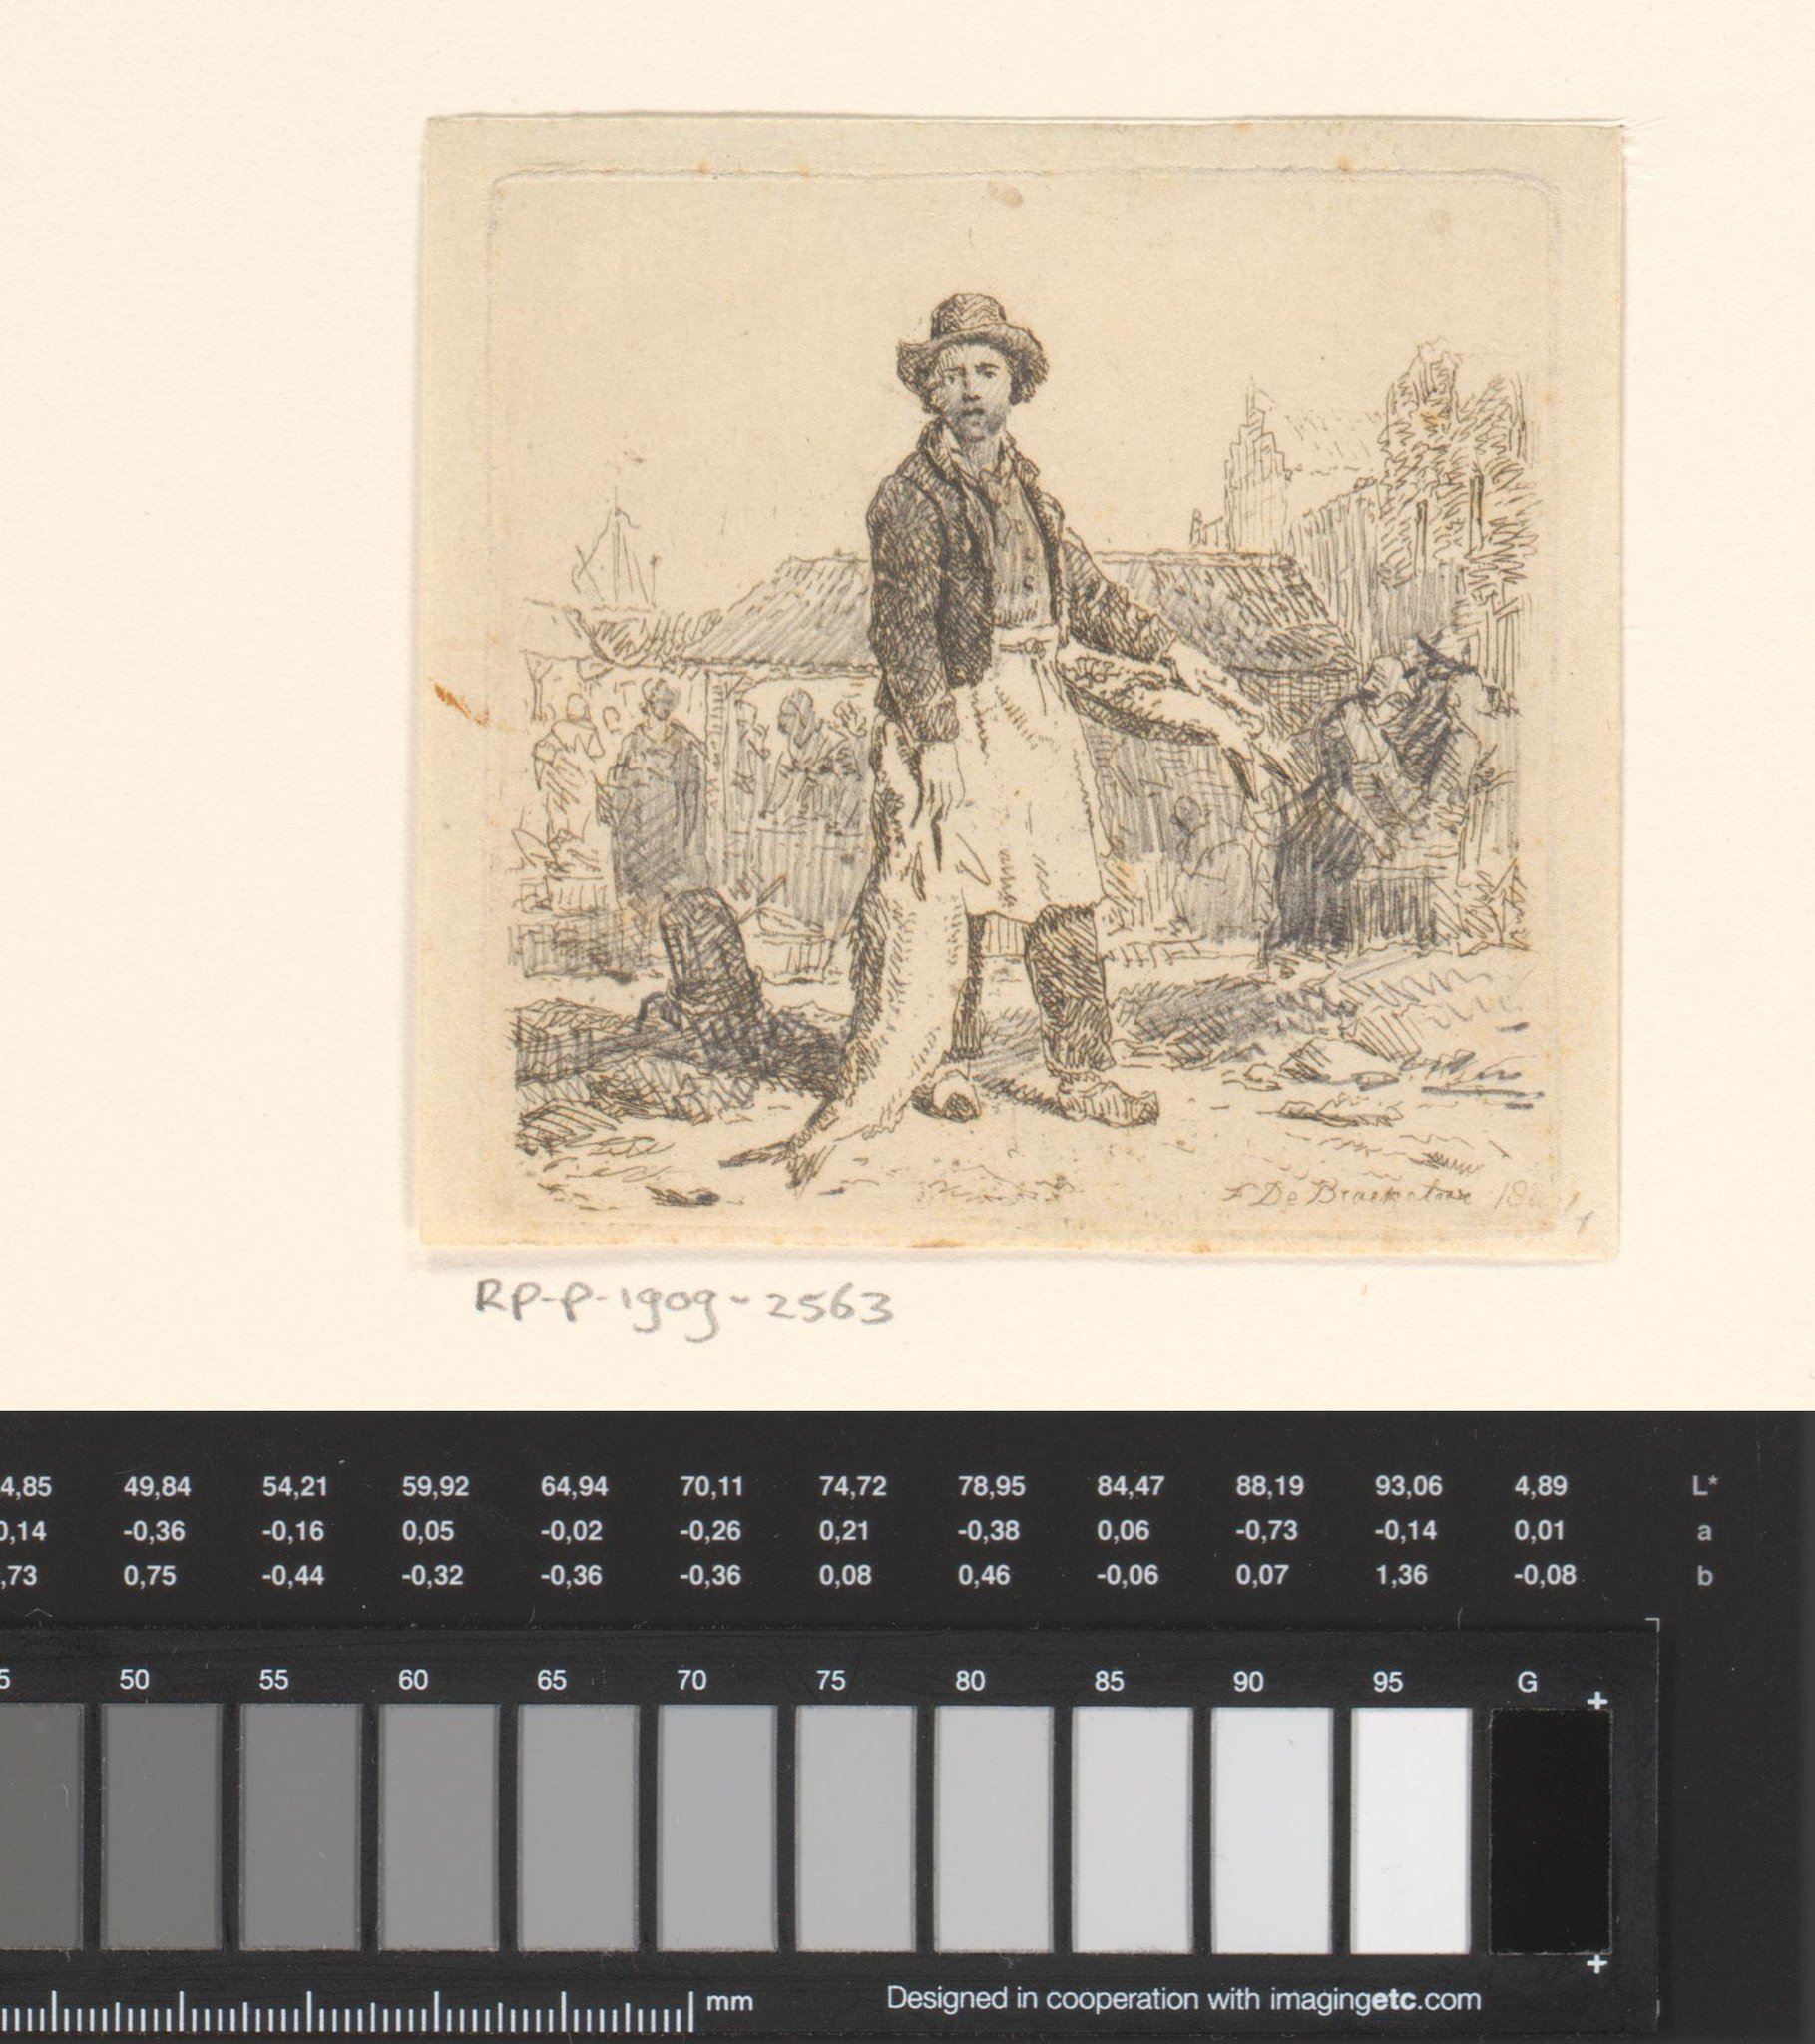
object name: print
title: Visverkoper op de markt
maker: ferdinand de braekeleer (i)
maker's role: draughtsman, print maker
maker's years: 1792-1883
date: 1820-1829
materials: paper, pencil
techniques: etching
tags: fishes, market, selling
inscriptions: collector's mark: Lugt 2228, collector's mark: Lugt 1485